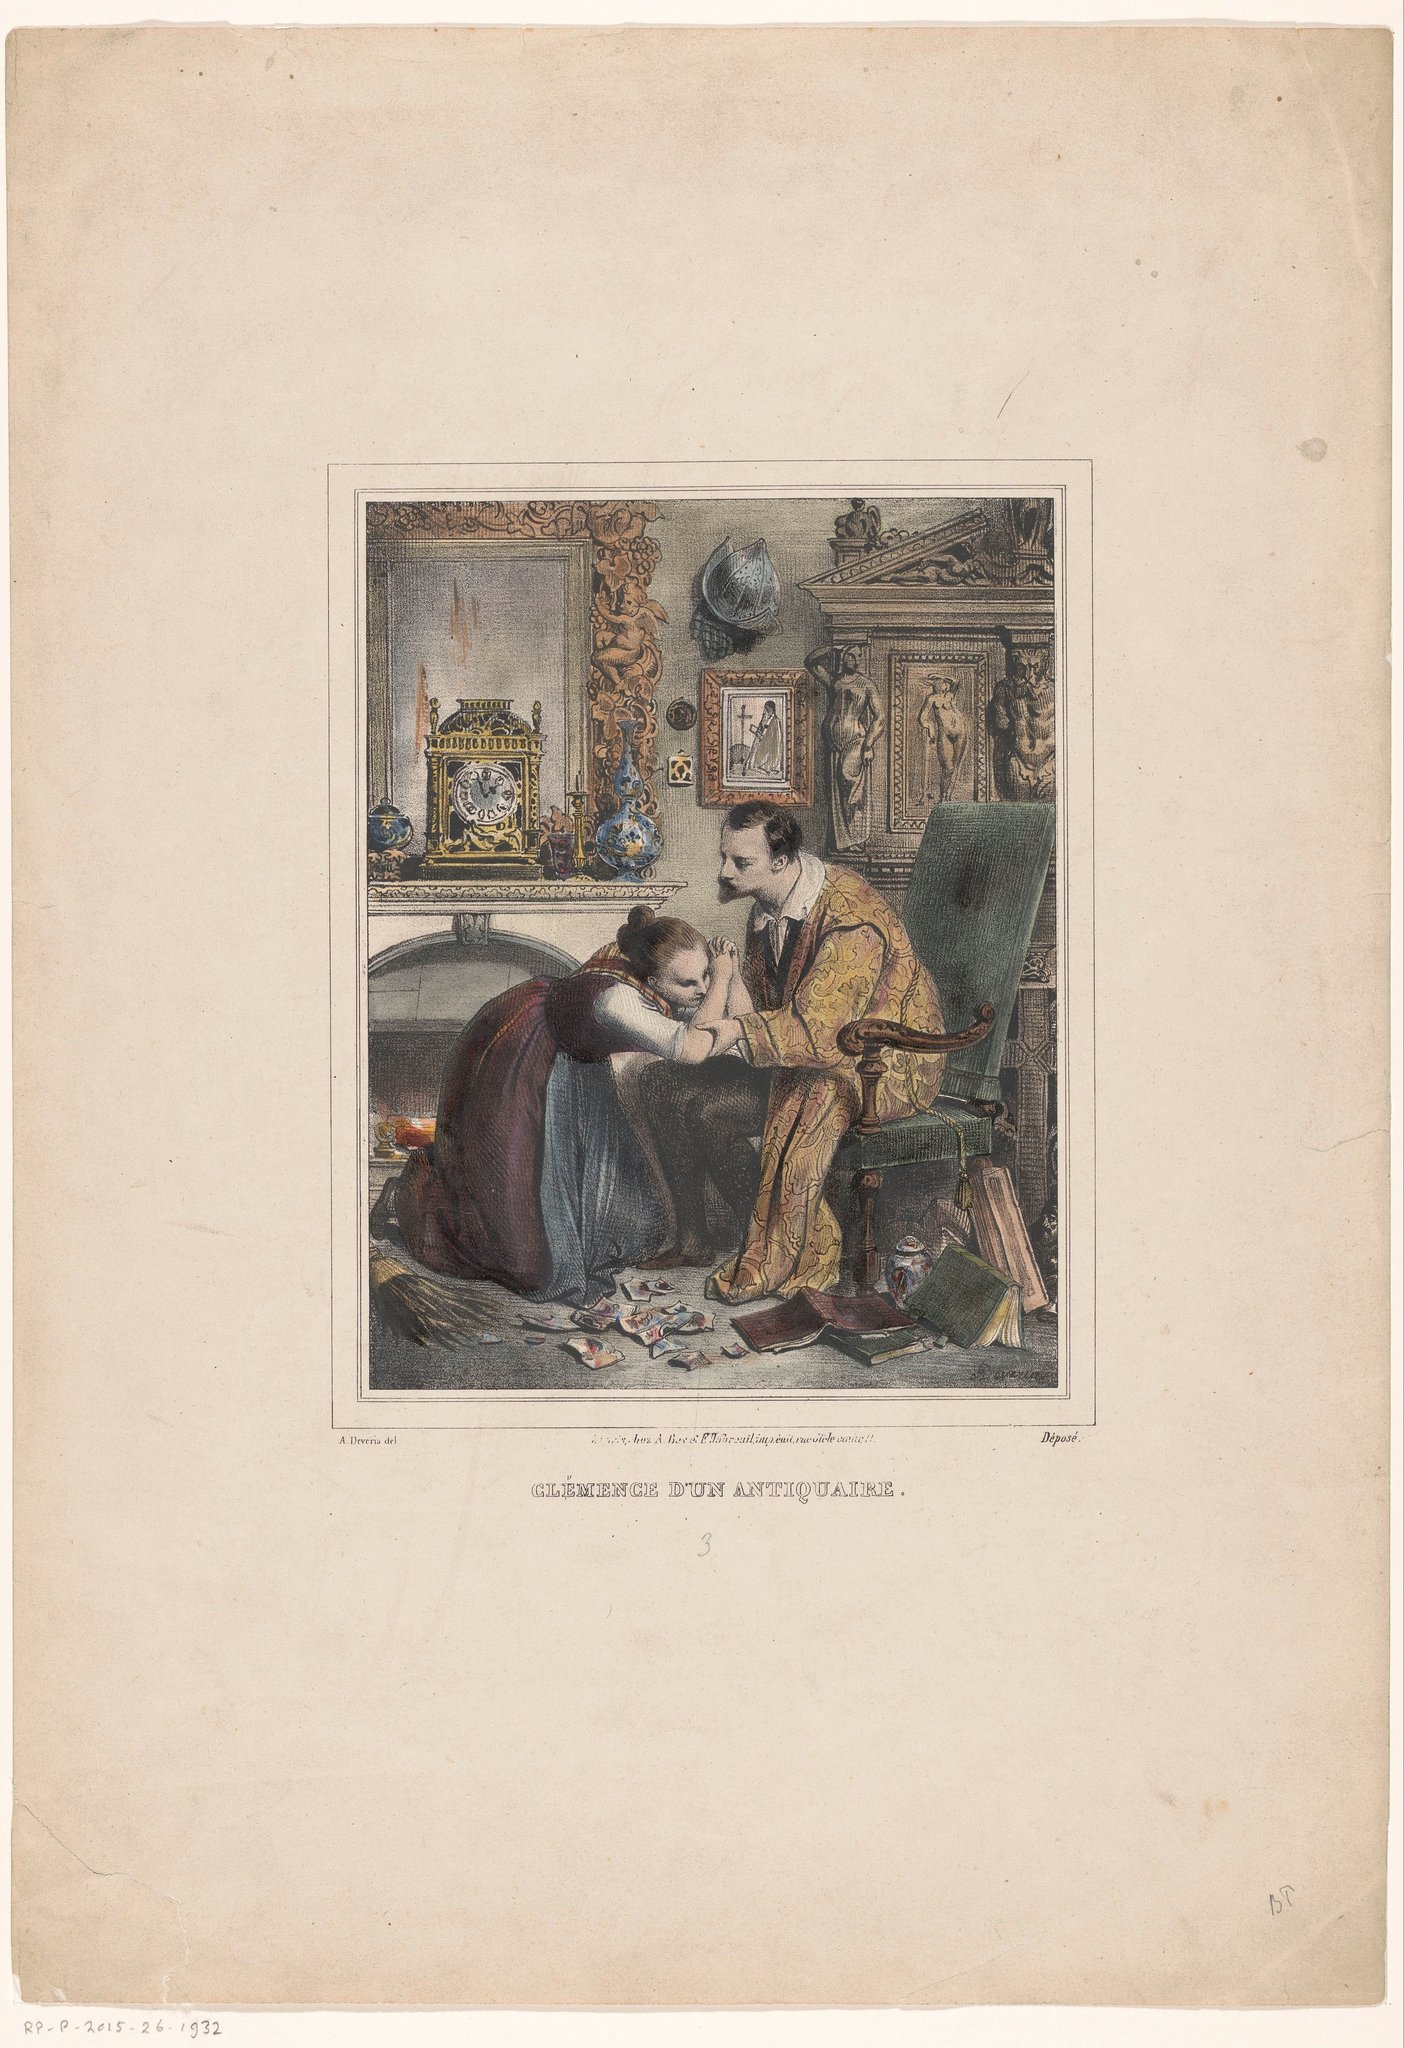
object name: print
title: Genade van de verzamelaar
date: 1835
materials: paper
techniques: hand coloring, lithograph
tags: forgivingness, container of ceramics: jar, jug, pot, vase (+ broken, damaged), housekeeper, art collector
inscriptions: label, : ‘Déposé’, collector's mark: Lugt 4780, collector's mark: Lugt 2228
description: In een interieur vol kunstvoorwerpen zit een verzamelaar op zijn stoel. Voor hem zit zijn schoonmaakster op haar knieën, smekend om vergiffenis. Op de grond liggen de scherven van de vaas die zij tijdens haar werkzaamheden heeft omgestoten.